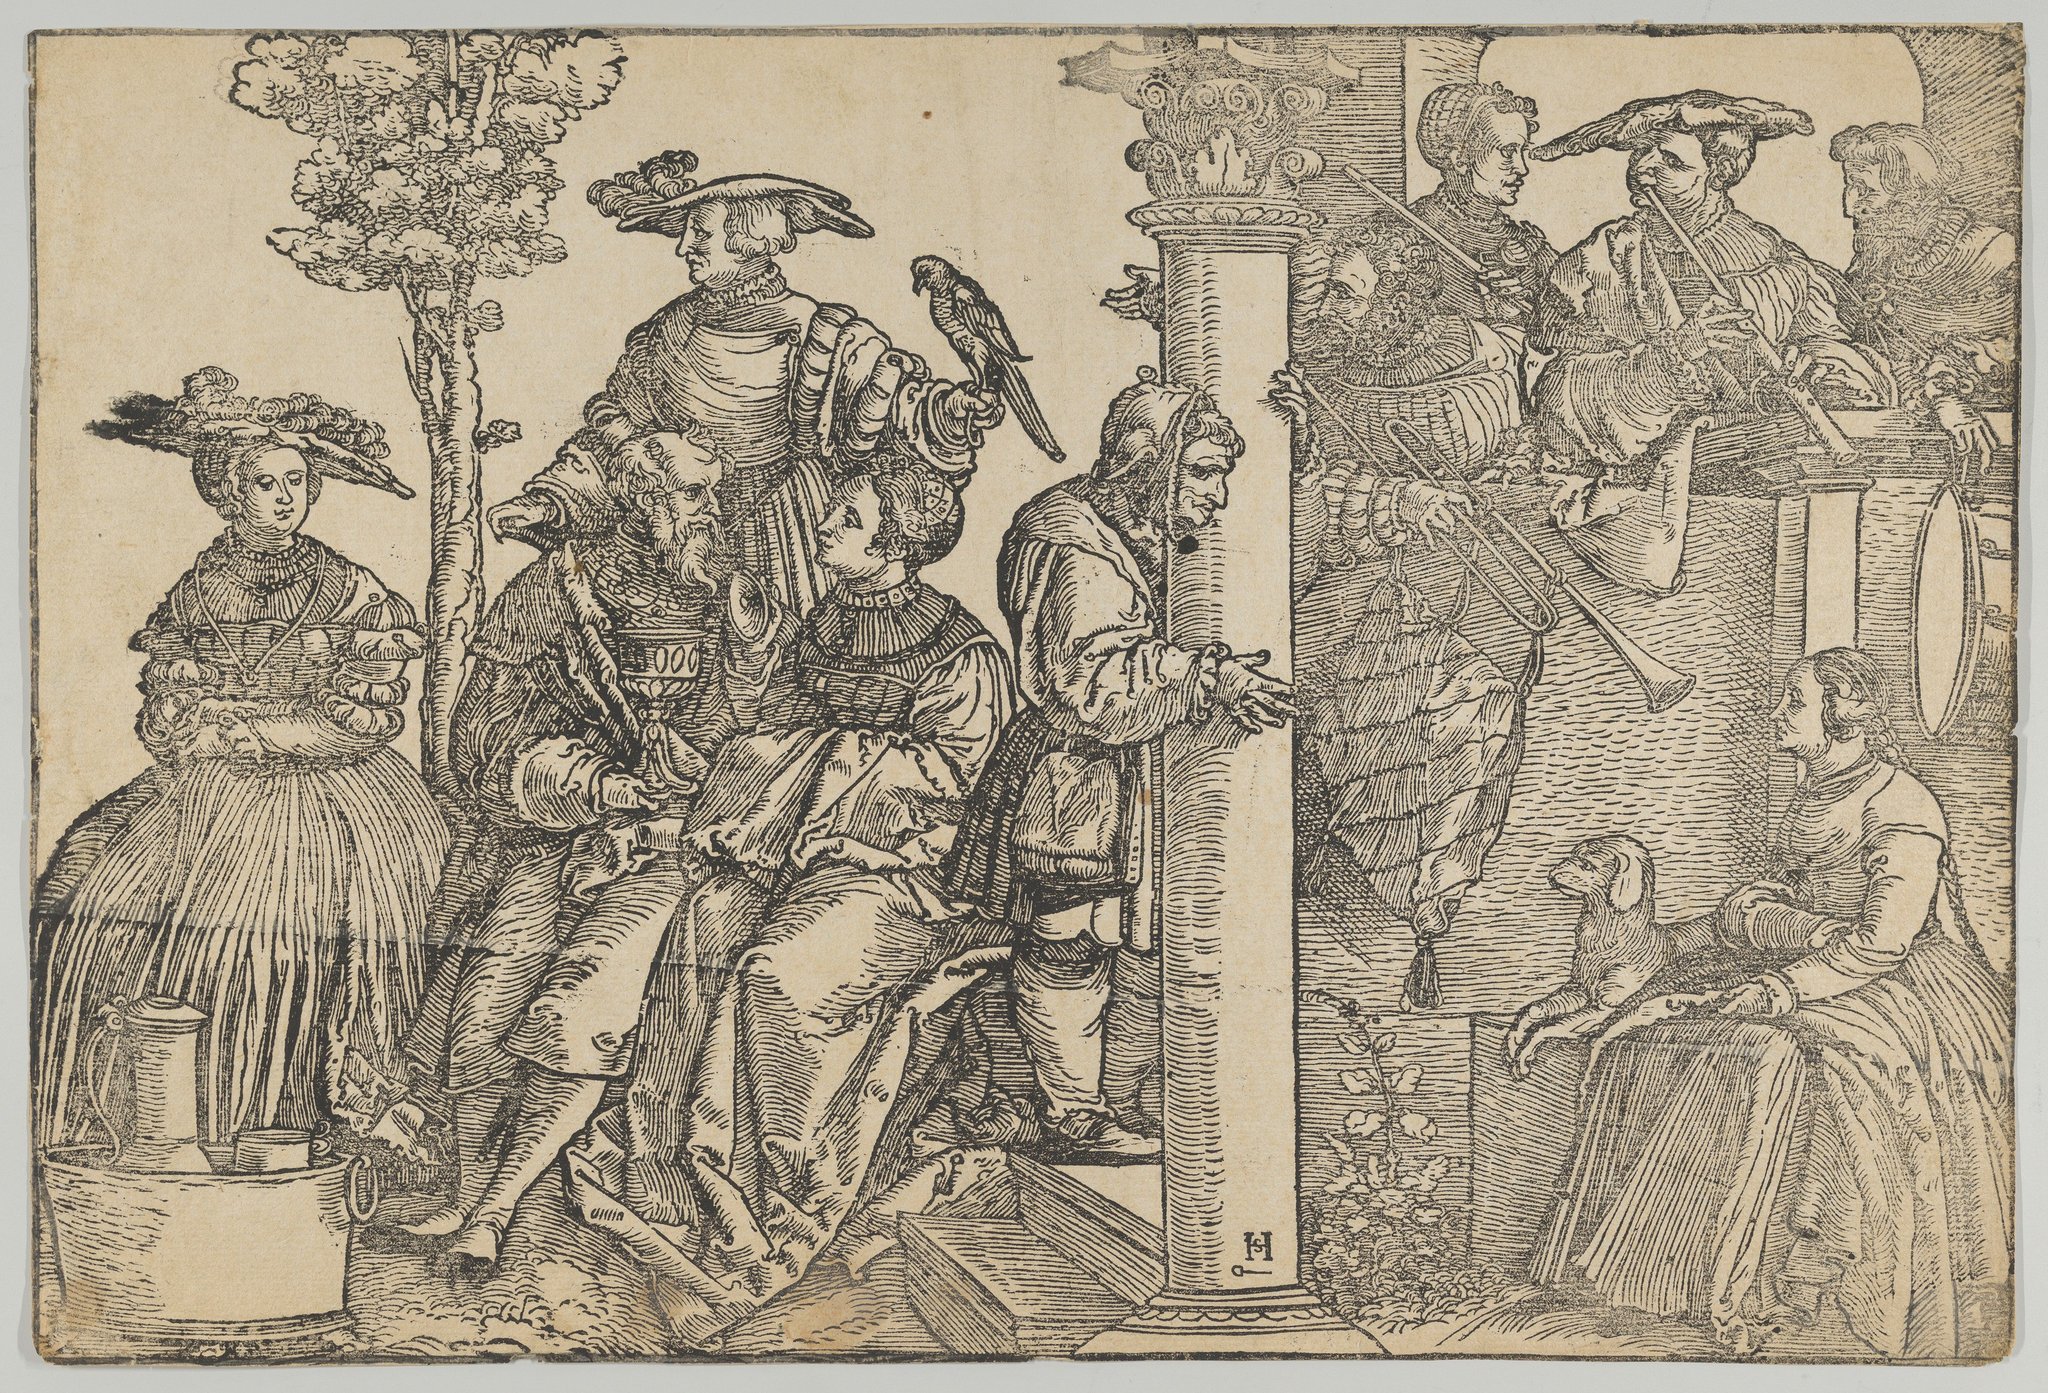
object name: print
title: Musicians and Onlookers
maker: hans schäufelein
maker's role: artist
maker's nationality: german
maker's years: 1480-1540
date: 1500-1540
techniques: woodcut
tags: musical instruments,birds,men,women,musicians